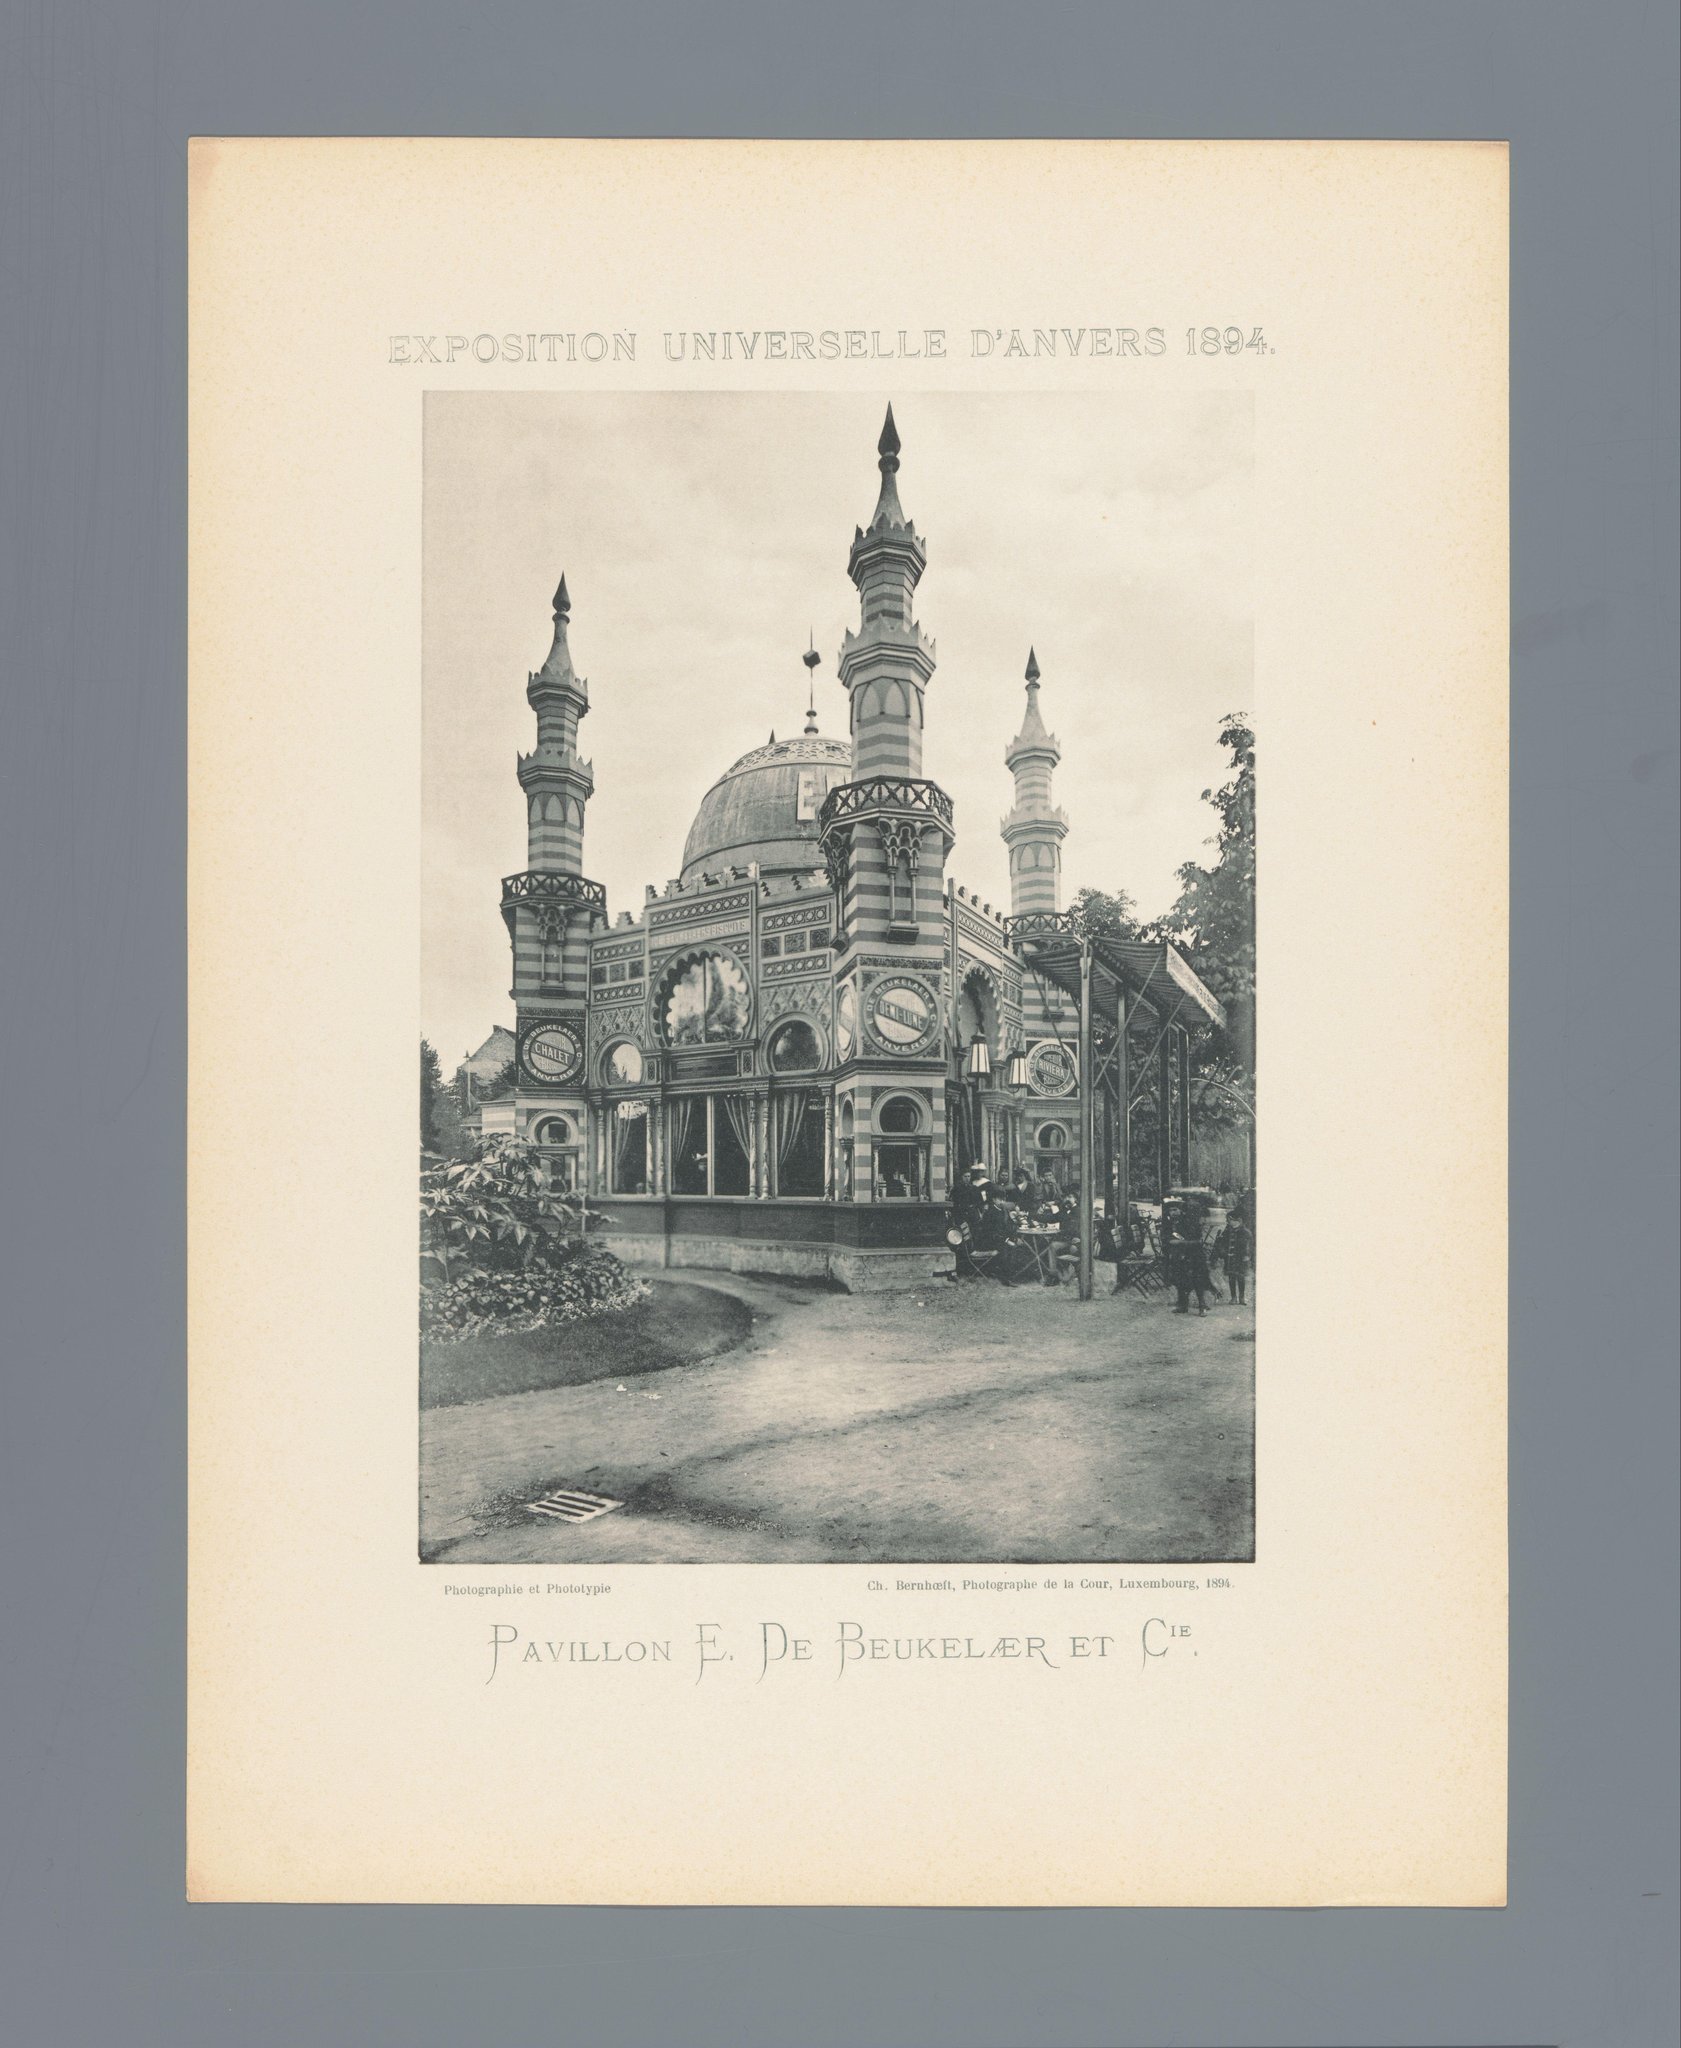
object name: photomechanical print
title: Paviljoen van E. de Beukelaer et Cie tijdens de Wereldtentoonstelling van 1894 te Antwerpen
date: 1894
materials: paper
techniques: photograph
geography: luxembourg city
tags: world fair, world exhibition, civic architecture; edifices; dwellings, antwerp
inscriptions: inscription: ‘Exposition Universelle D'Anvers 1894’